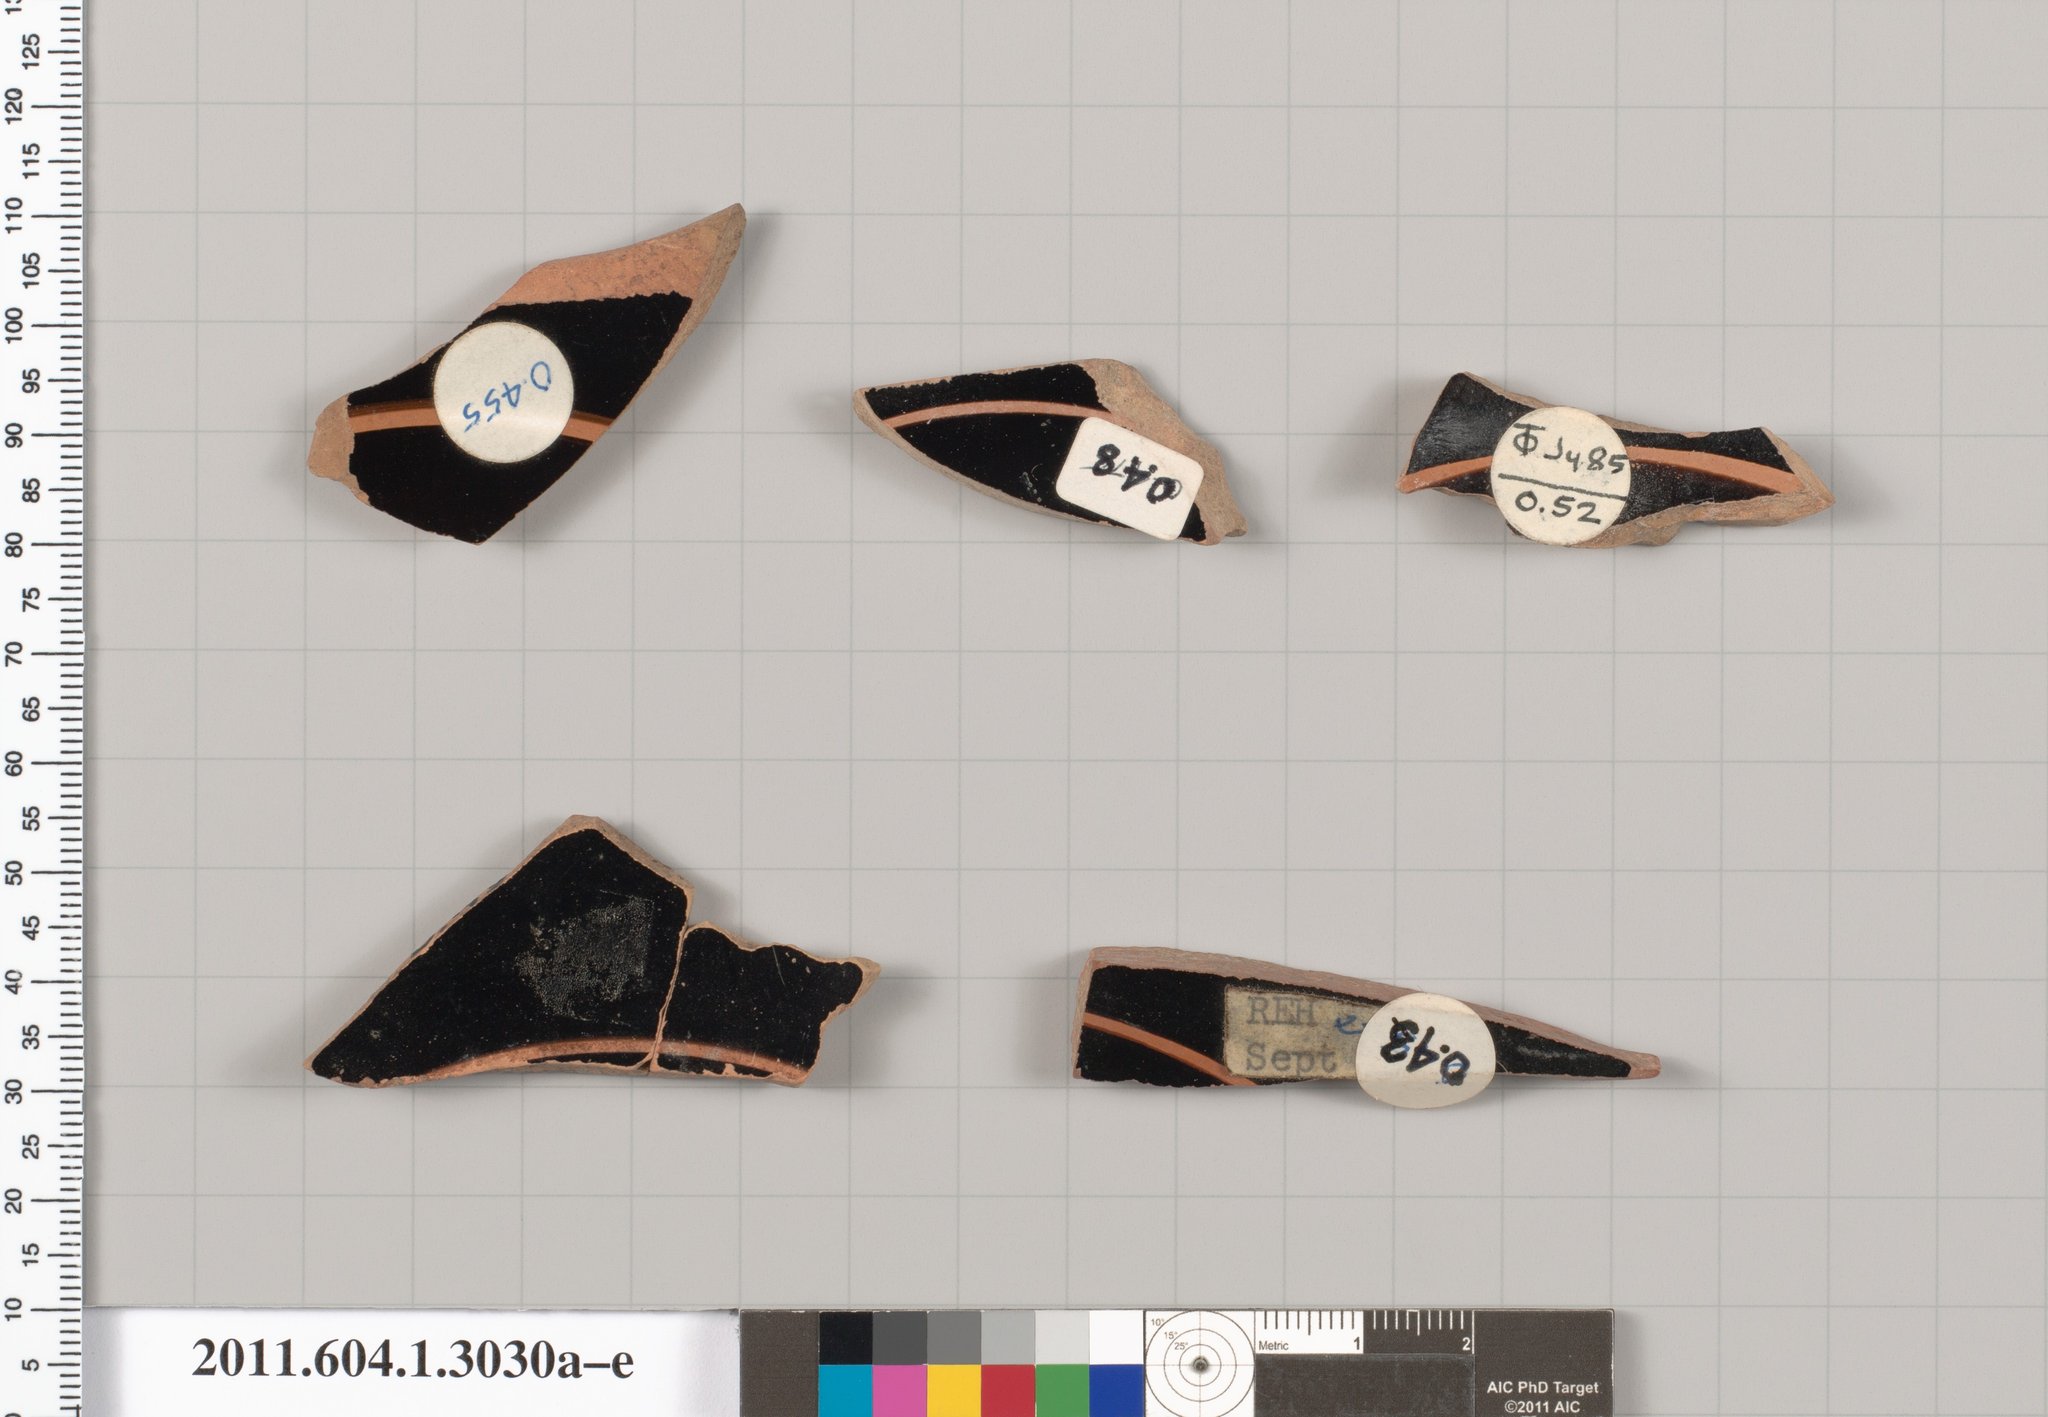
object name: kylix fragment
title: Terracotta fragments of kylikes (drinking cups)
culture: greek, attic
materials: terracotta